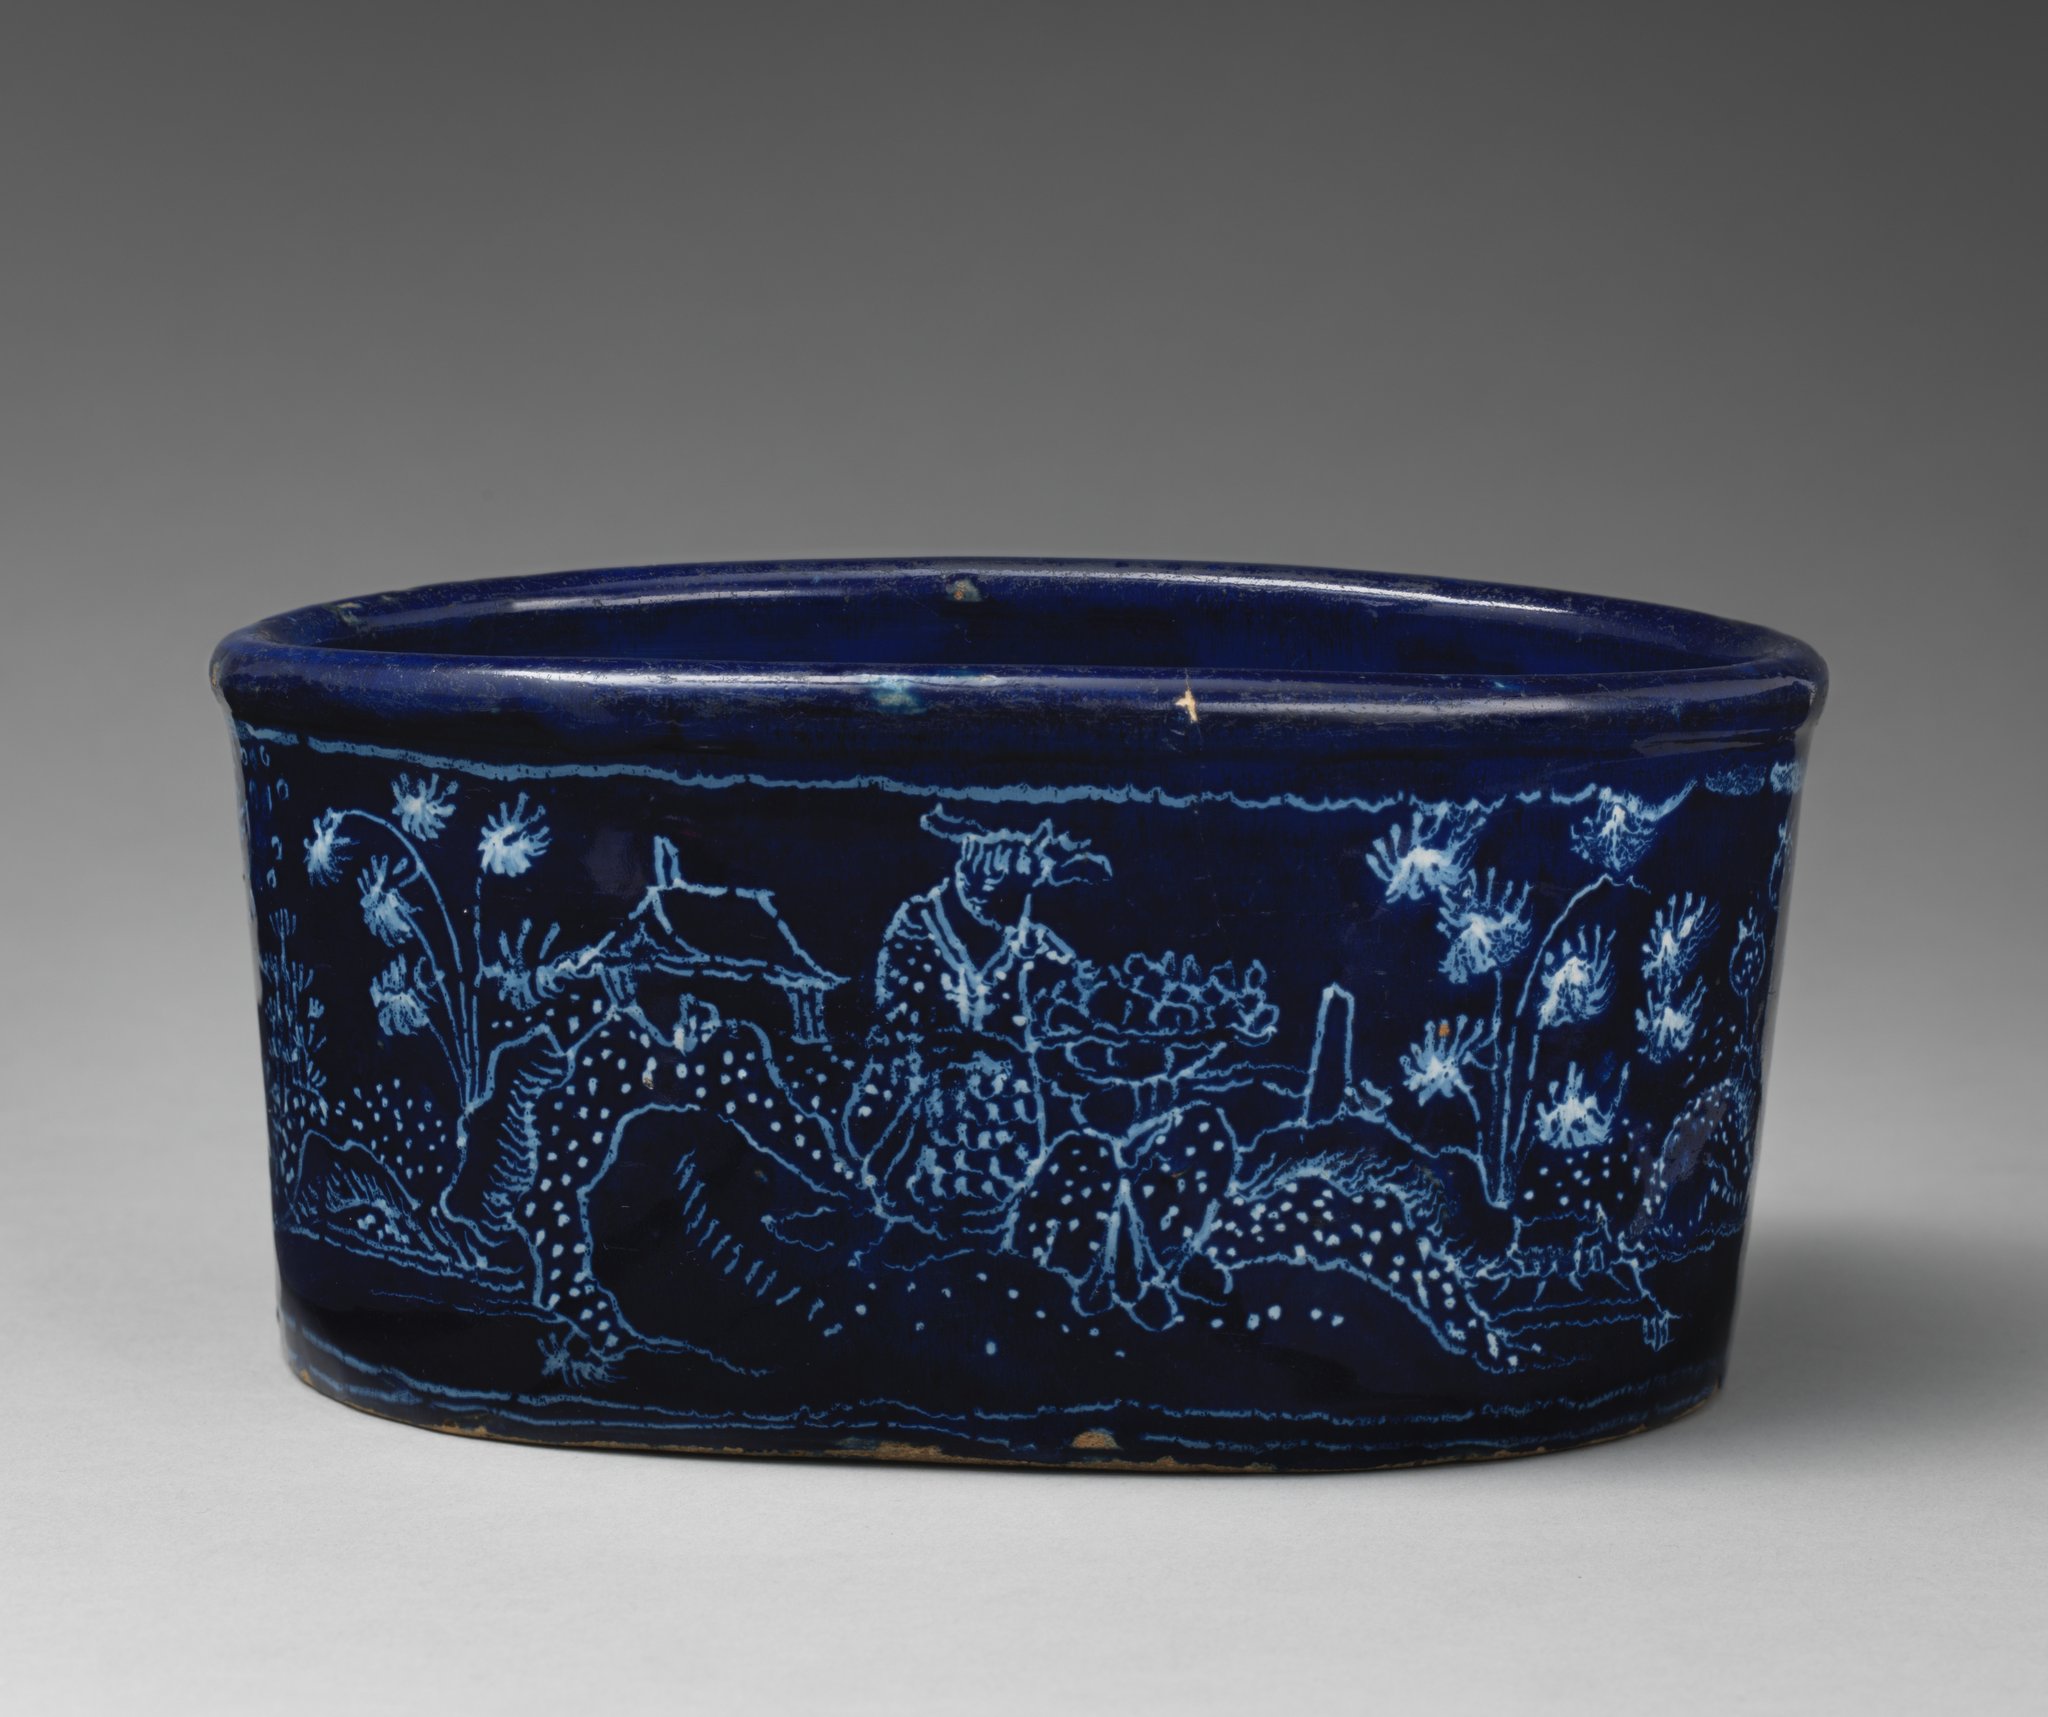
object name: butter dish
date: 1651-1700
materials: earthenware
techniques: glazing